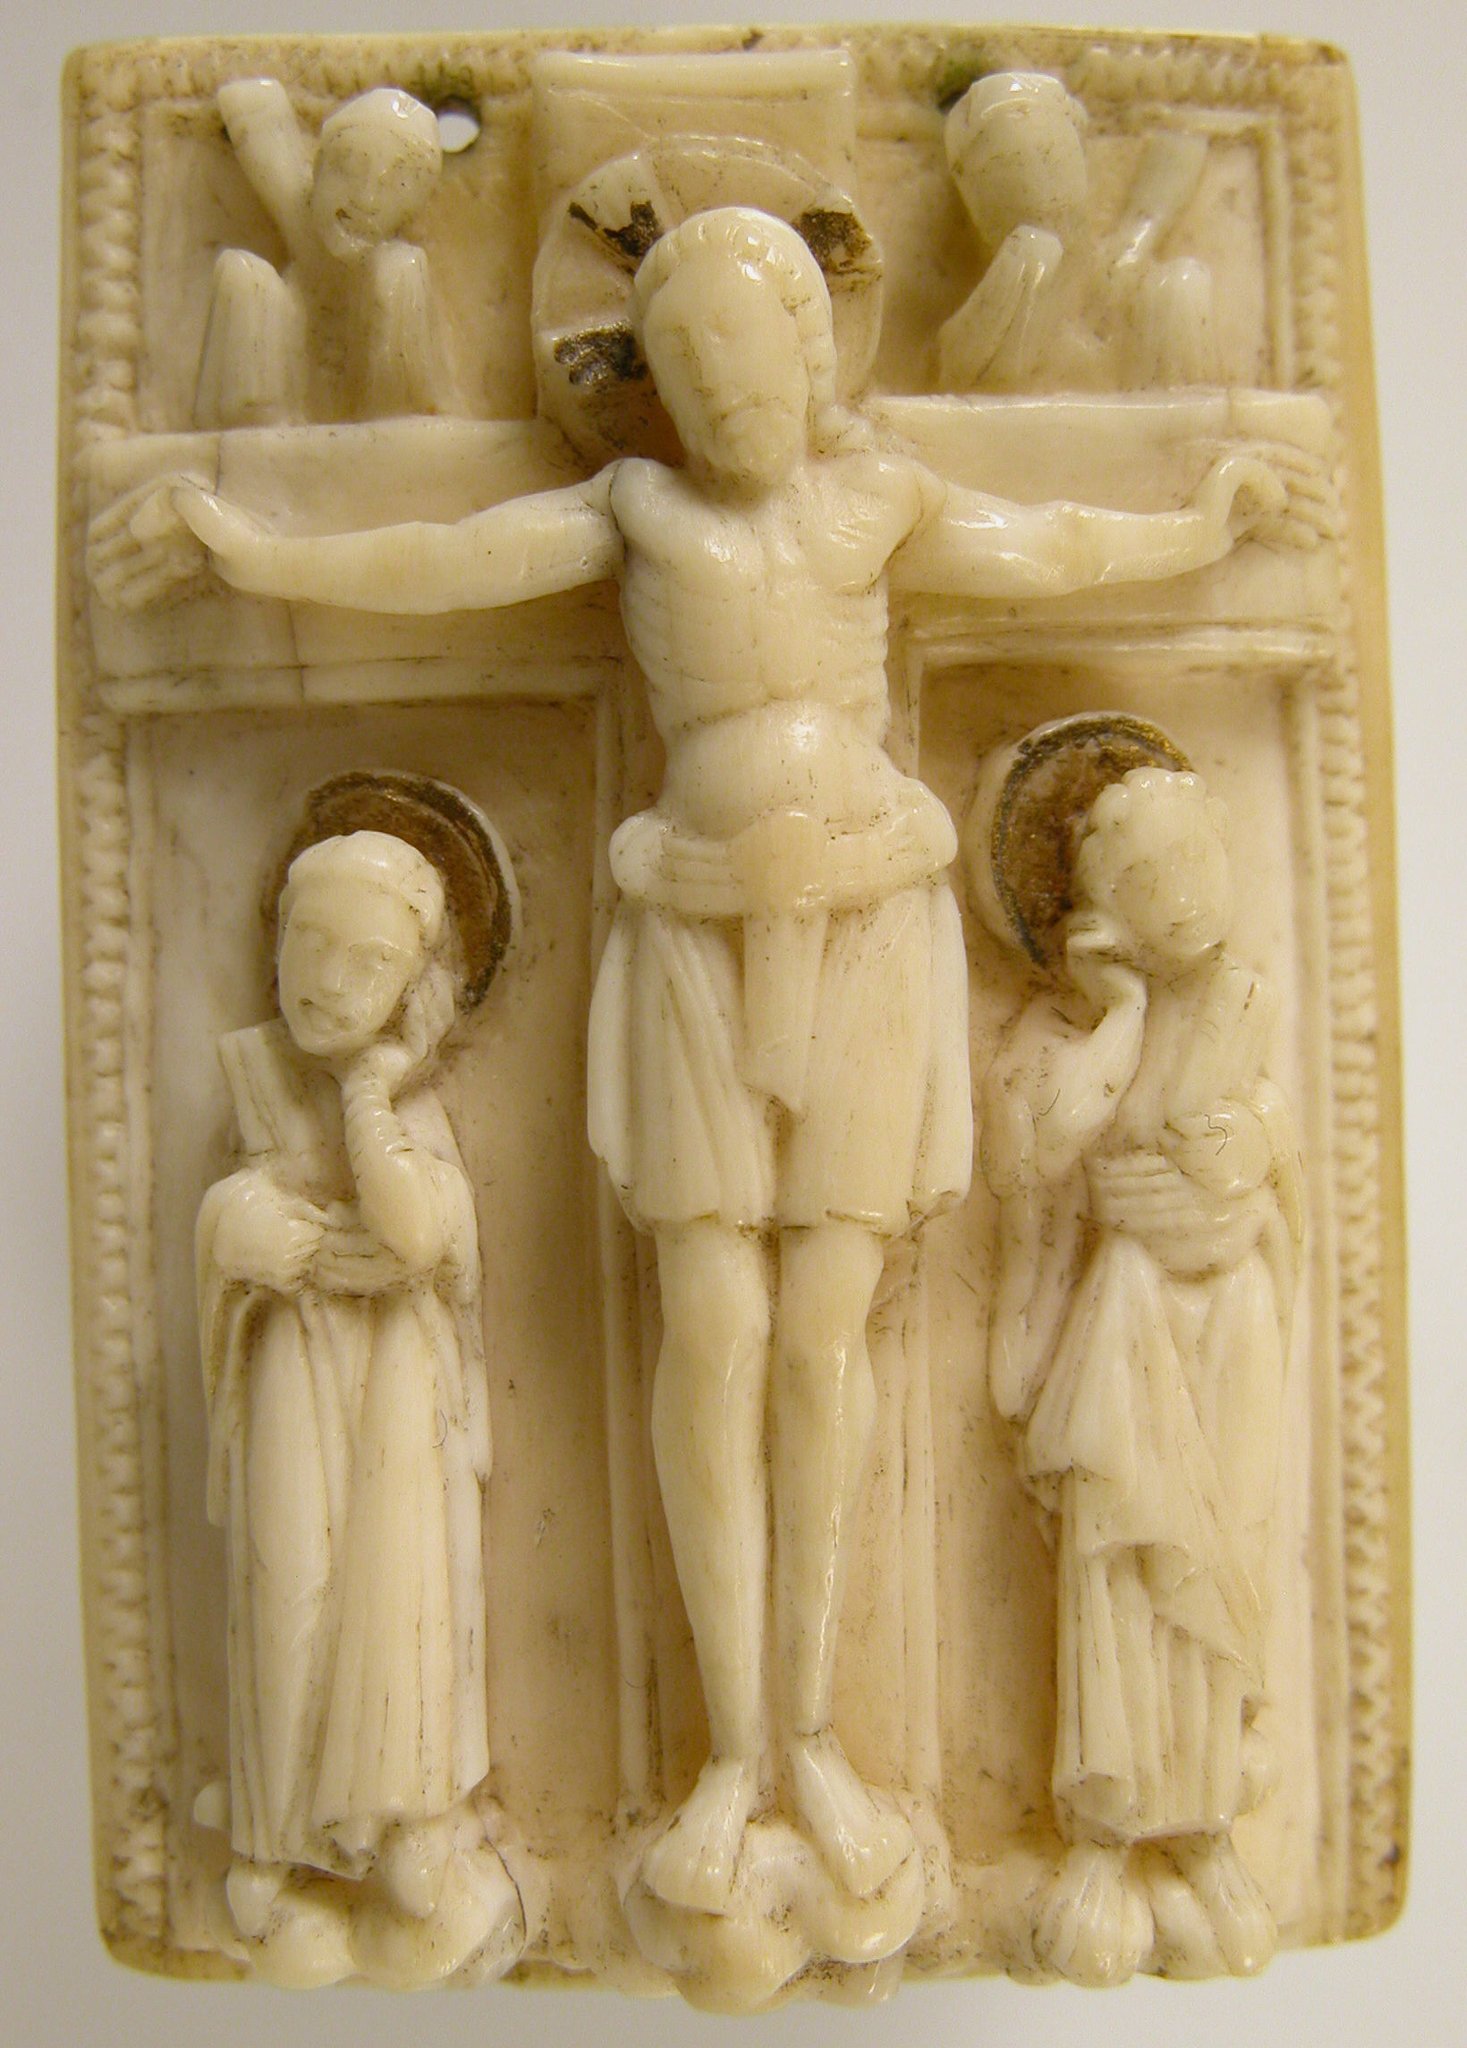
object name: plaque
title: Ivory Plaque with the Crucifixion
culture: ottonian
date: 1000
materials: ivory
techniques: gilding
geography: germany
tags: christ,virgin mary,crucifixion,saints